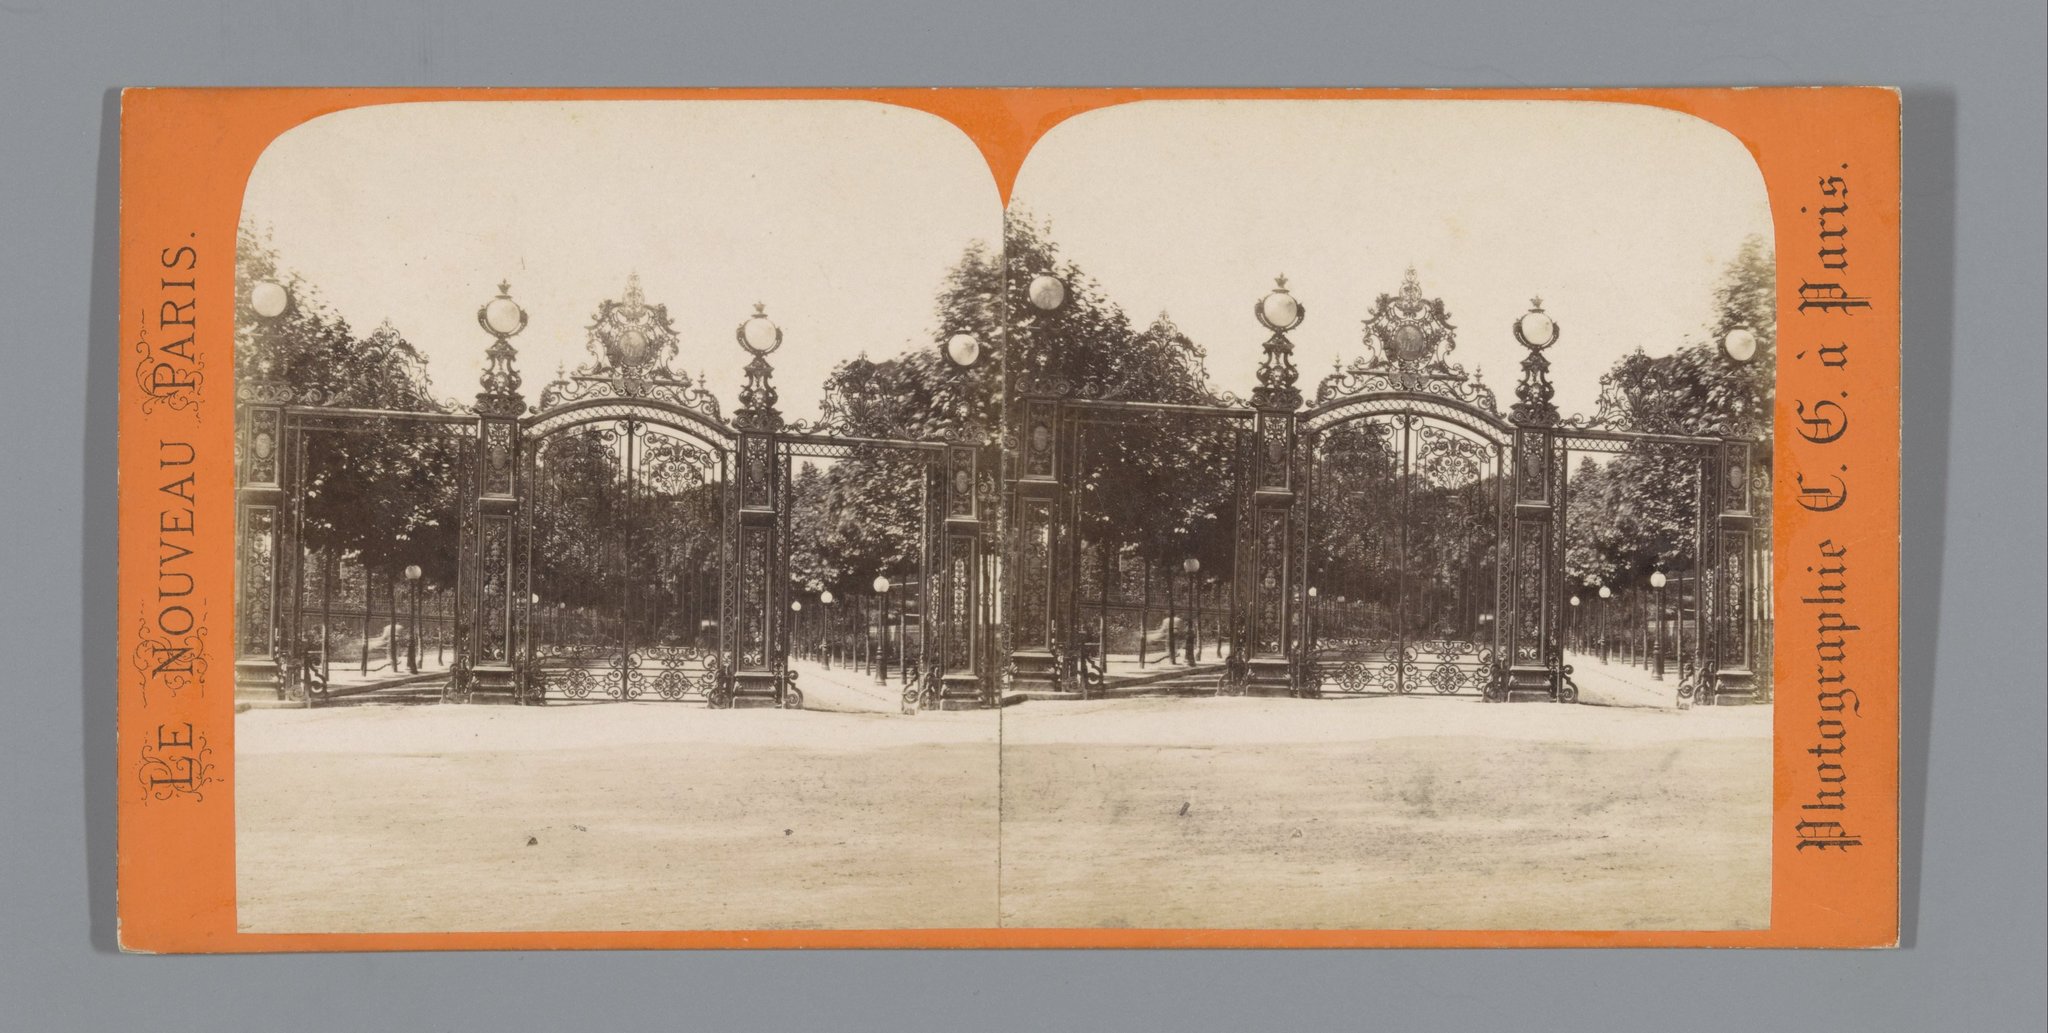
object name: stereograph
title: Hek van het Parc Monceau te Parijs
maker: charles gérard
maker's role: fotograaf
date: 1850-1875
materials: cardboard, photographic support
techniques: albumen print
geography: paris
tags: fence, wall, paling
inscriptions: inscription: ‘Grille du parc moncaux’